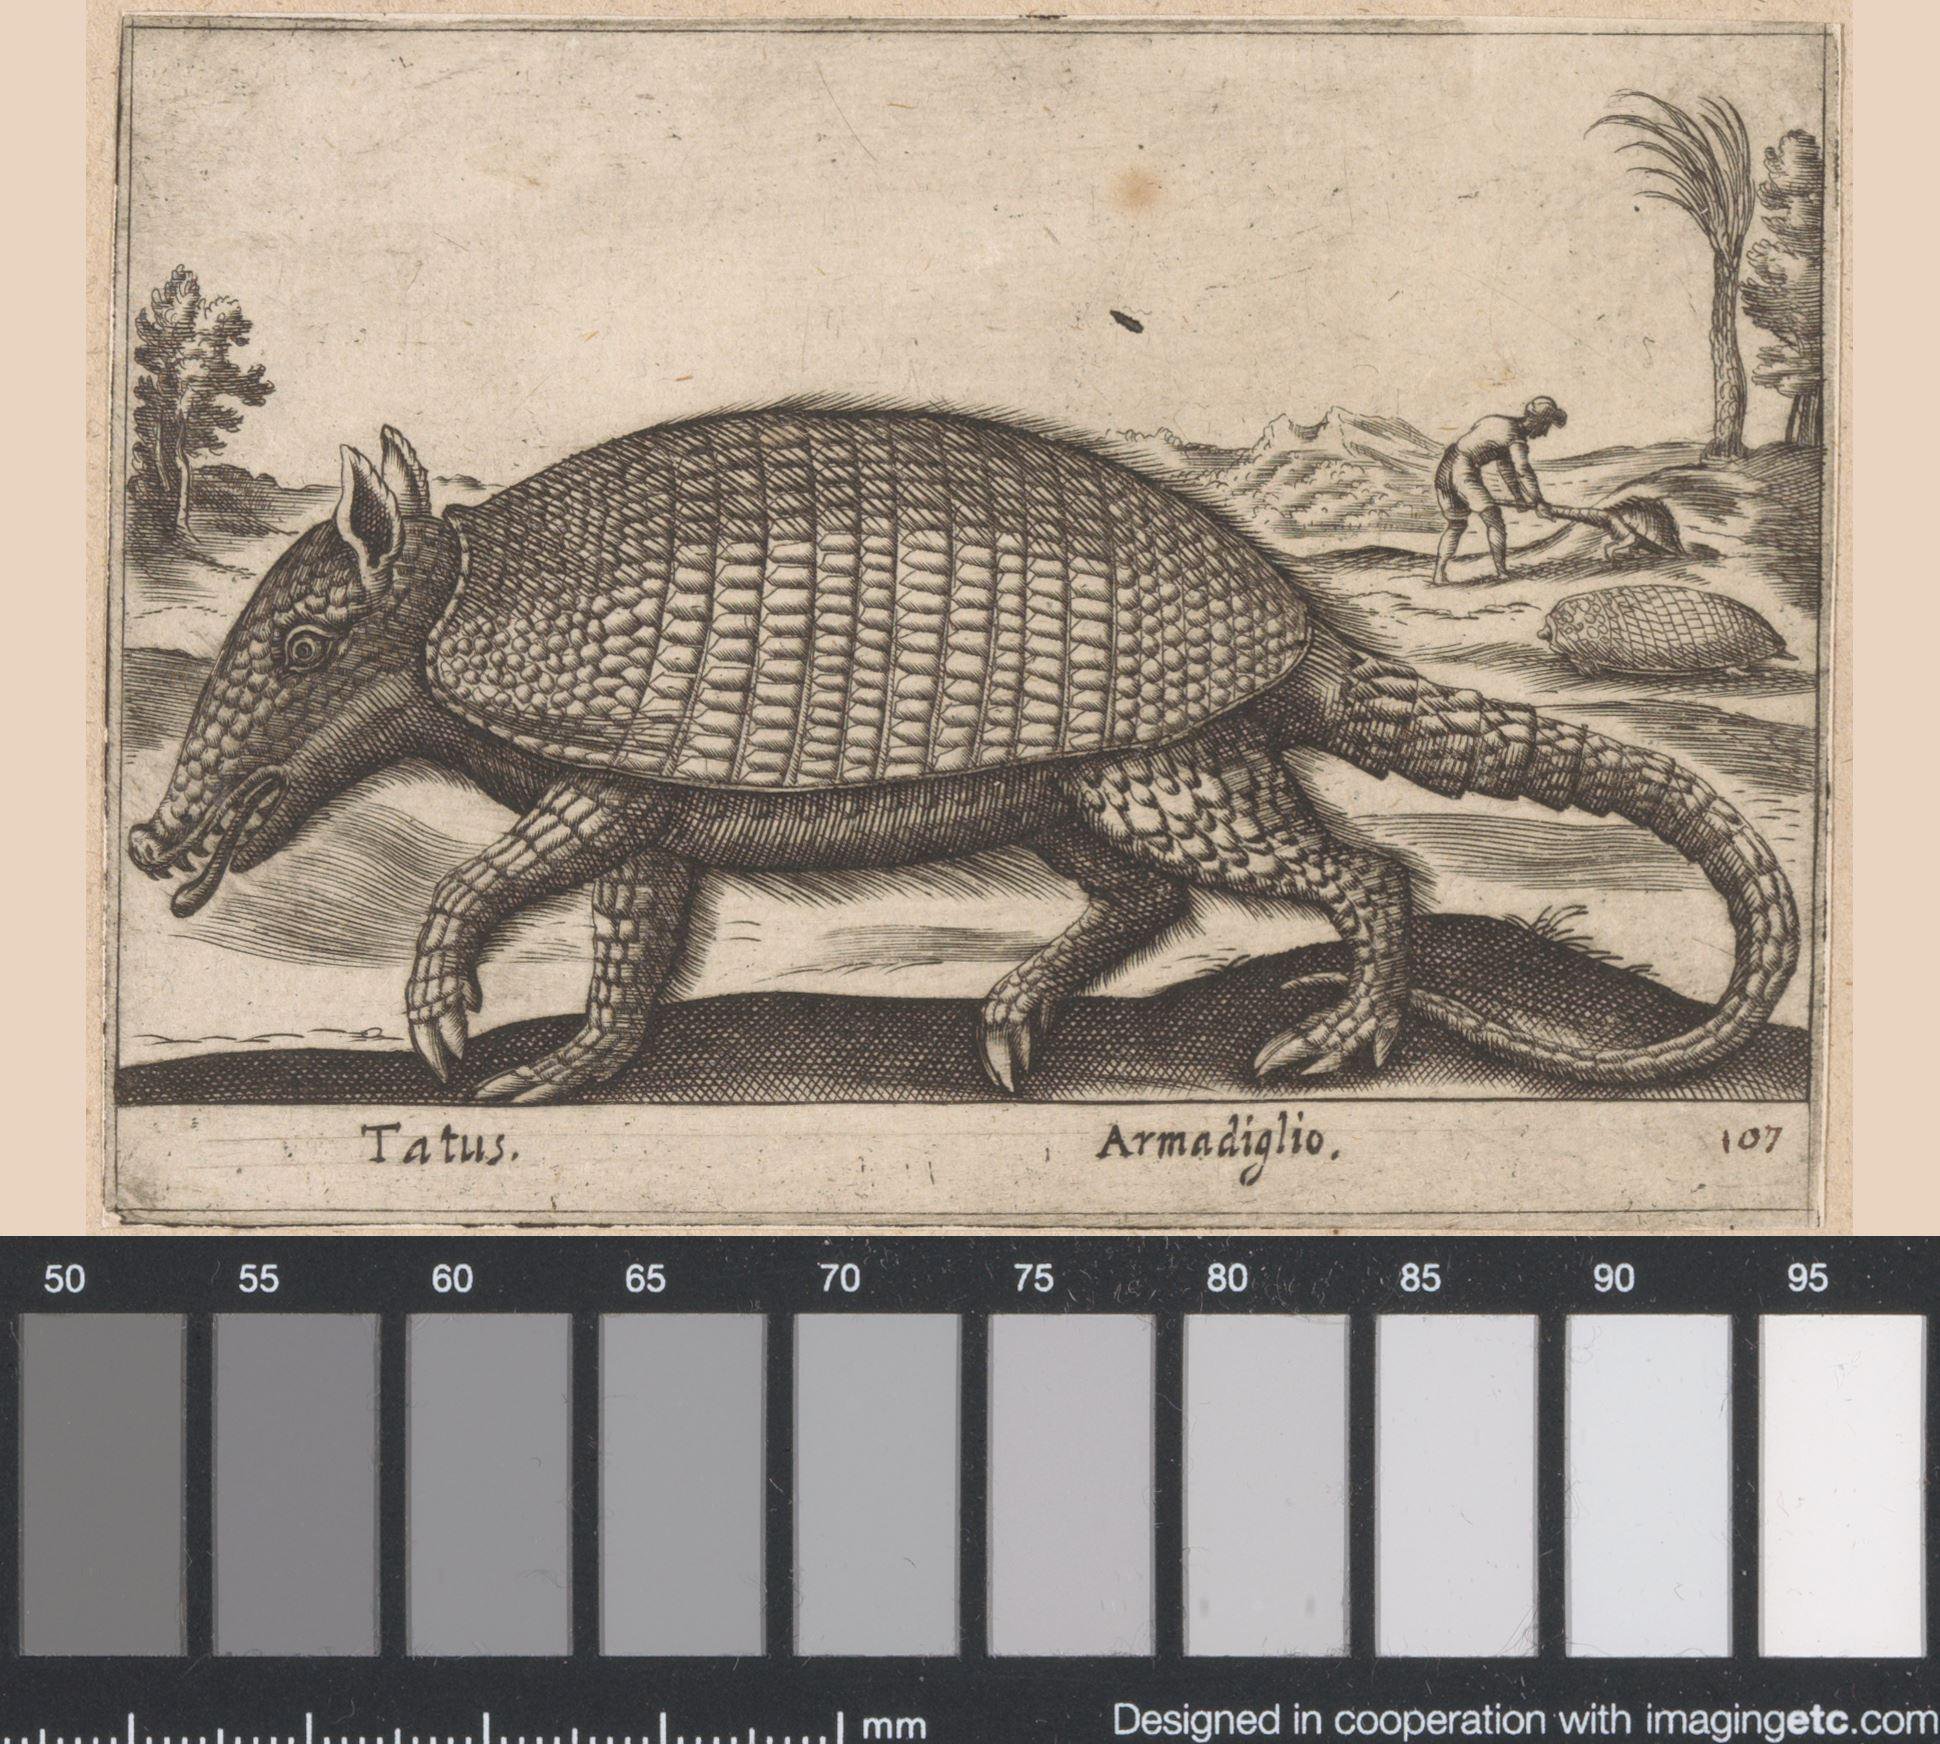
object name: print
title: Gordeldier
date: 1565-1630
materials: paper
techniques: etching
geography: italy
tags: other mammals: armadillo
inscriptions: collector's mark: Lugt 11, number: ‘107’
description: Deze prent maakt deel uit van een reeks prenten van dieren door Antonio Tempesta. Bekend is dat een tweede staat (met nummering) van deze serie is uitgegeven door Giovanni Giacomo de' Rossi in 1650. Onbekend is wie de eerste staat heeft uitgegeven en wanneer.